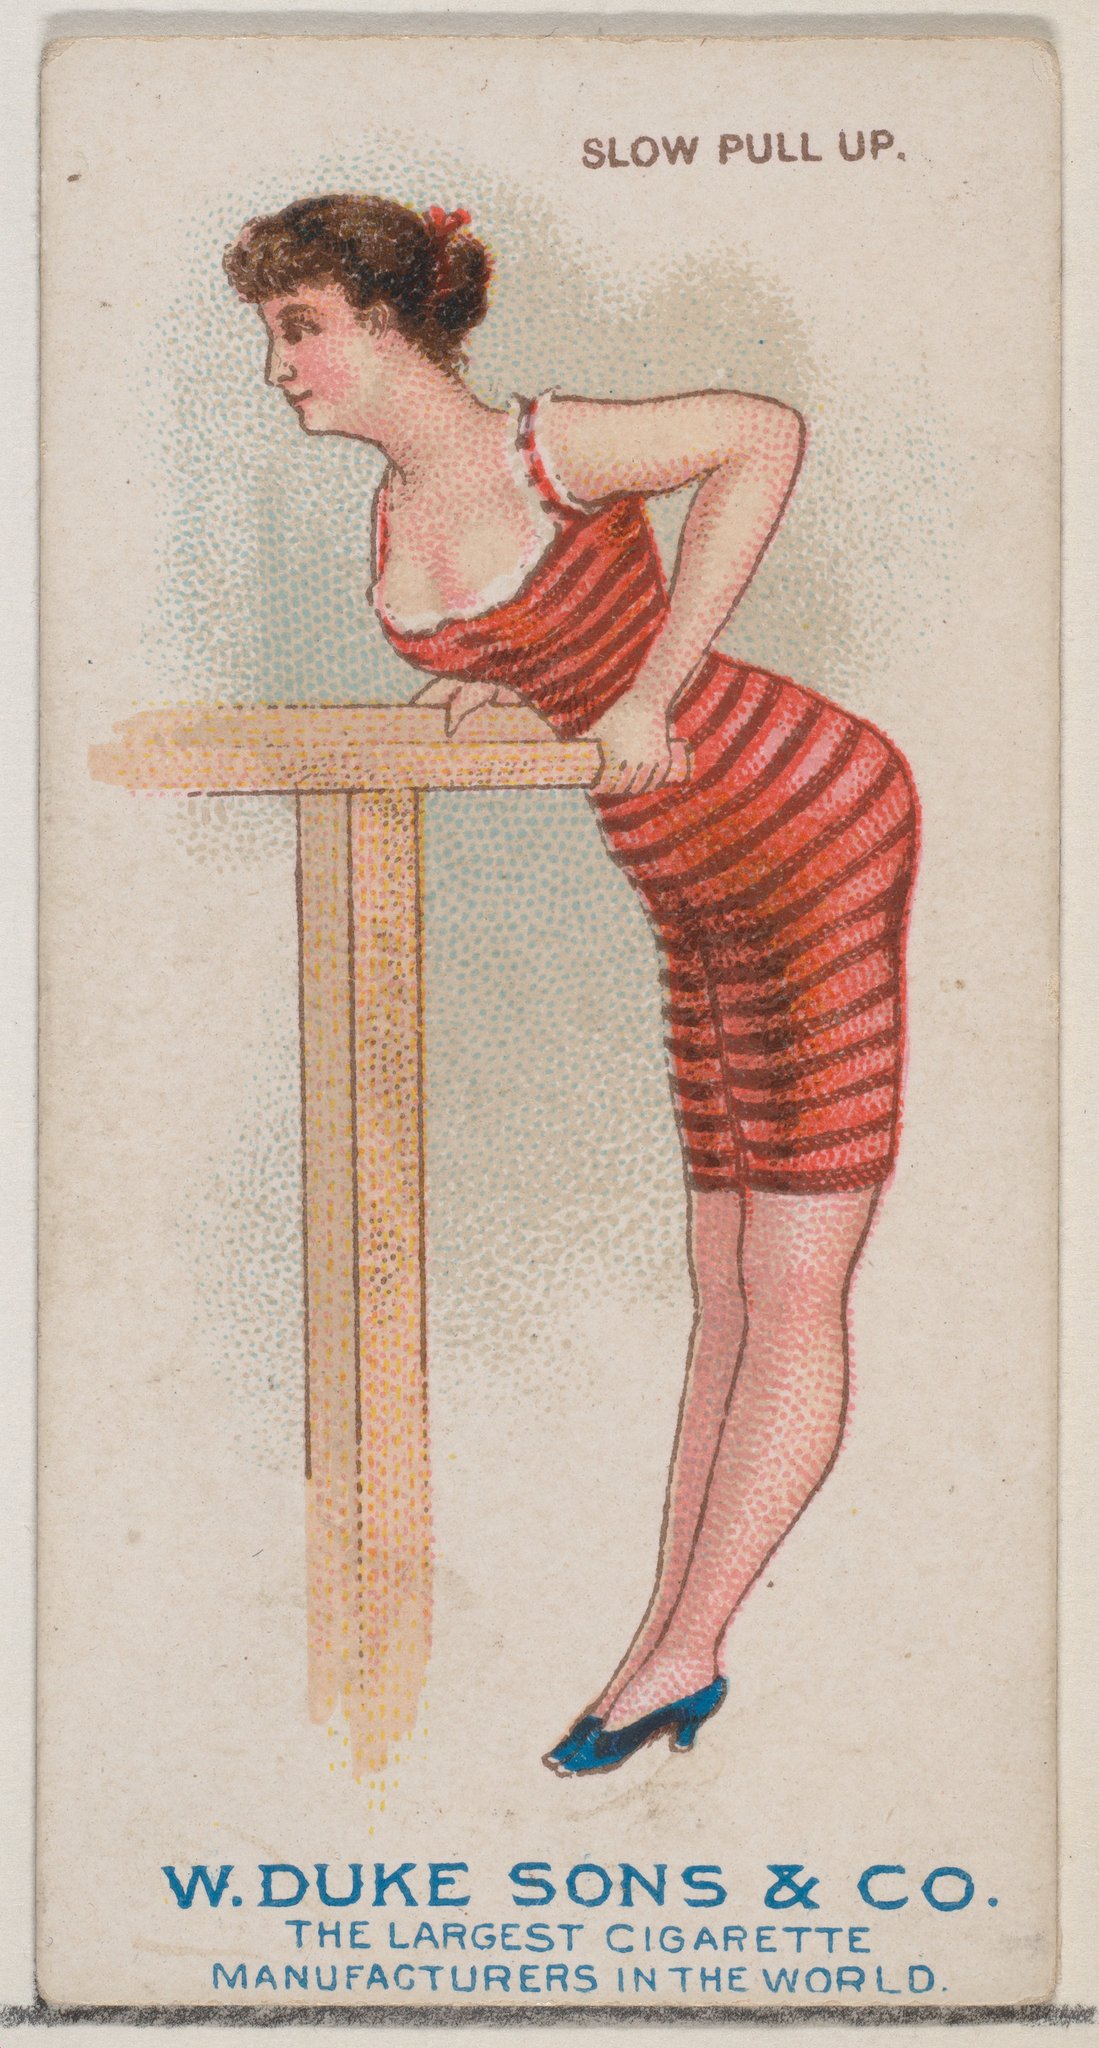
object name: print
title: Slow Pull Up, from the Gymnastic Exercises series (N77) for Duke brand cigarettes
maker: w. duke, sons & co.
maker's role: publisher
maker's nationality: american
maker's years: 1870-1920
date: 1887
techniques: color lithograph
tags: women,sports,athletes